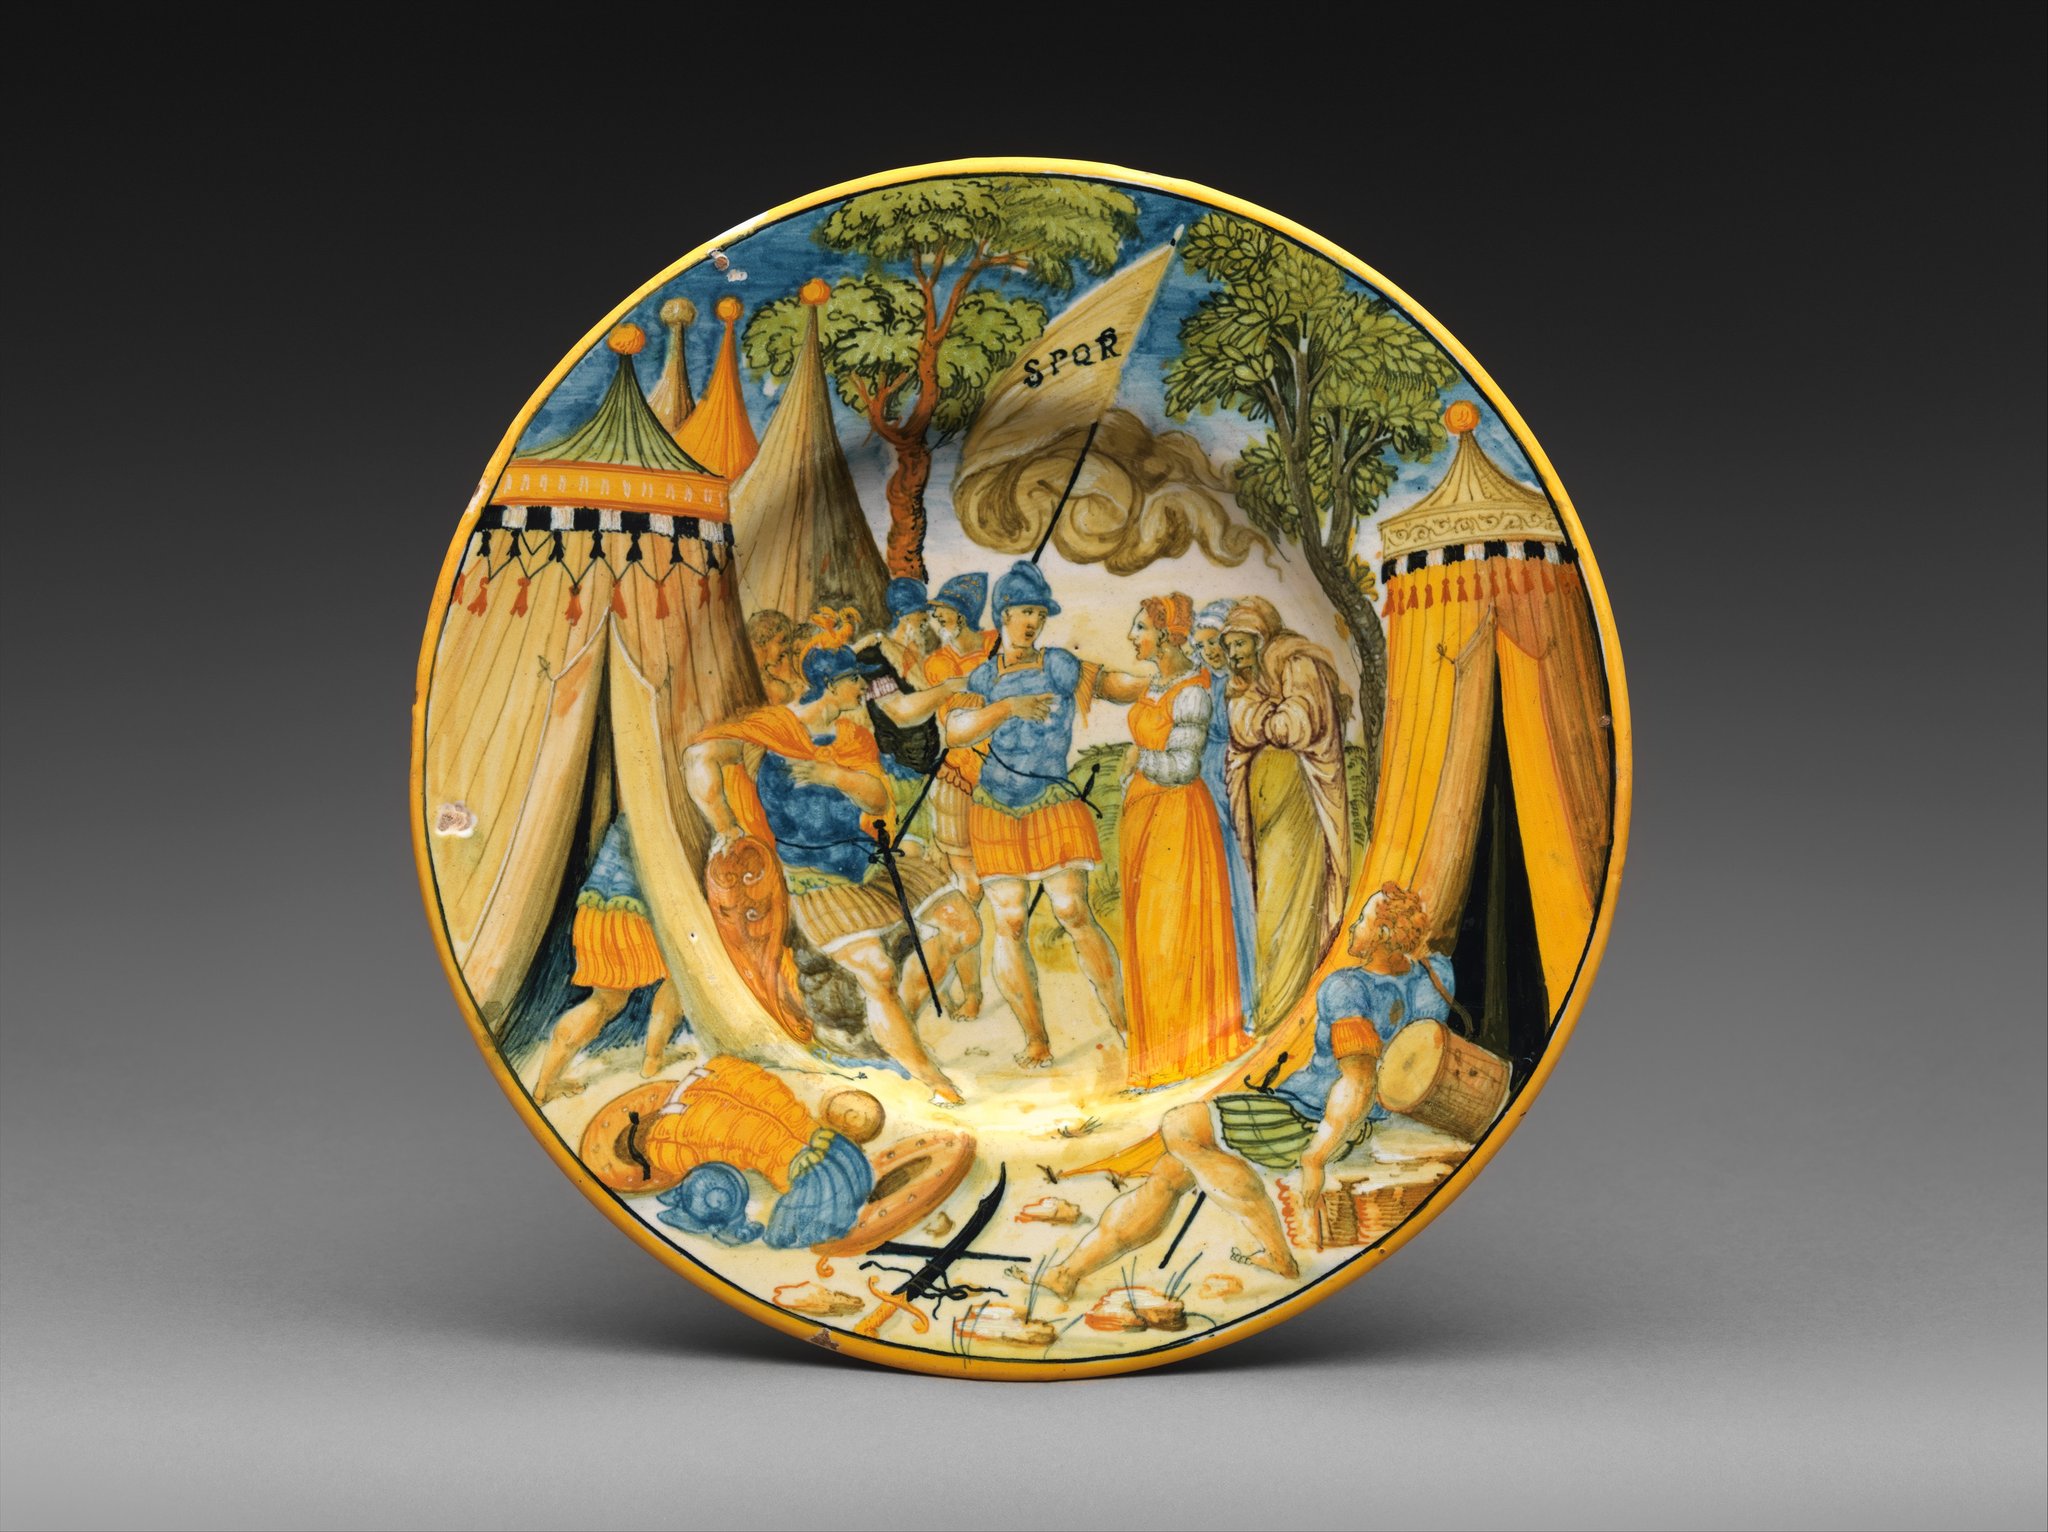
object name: plate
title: Plate with The Continence of Scipio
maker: francesco durantino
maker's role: artist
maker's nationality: italian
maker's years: 1500-1599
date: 1545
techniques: maiolica, glazing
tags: tents,men,women,trees